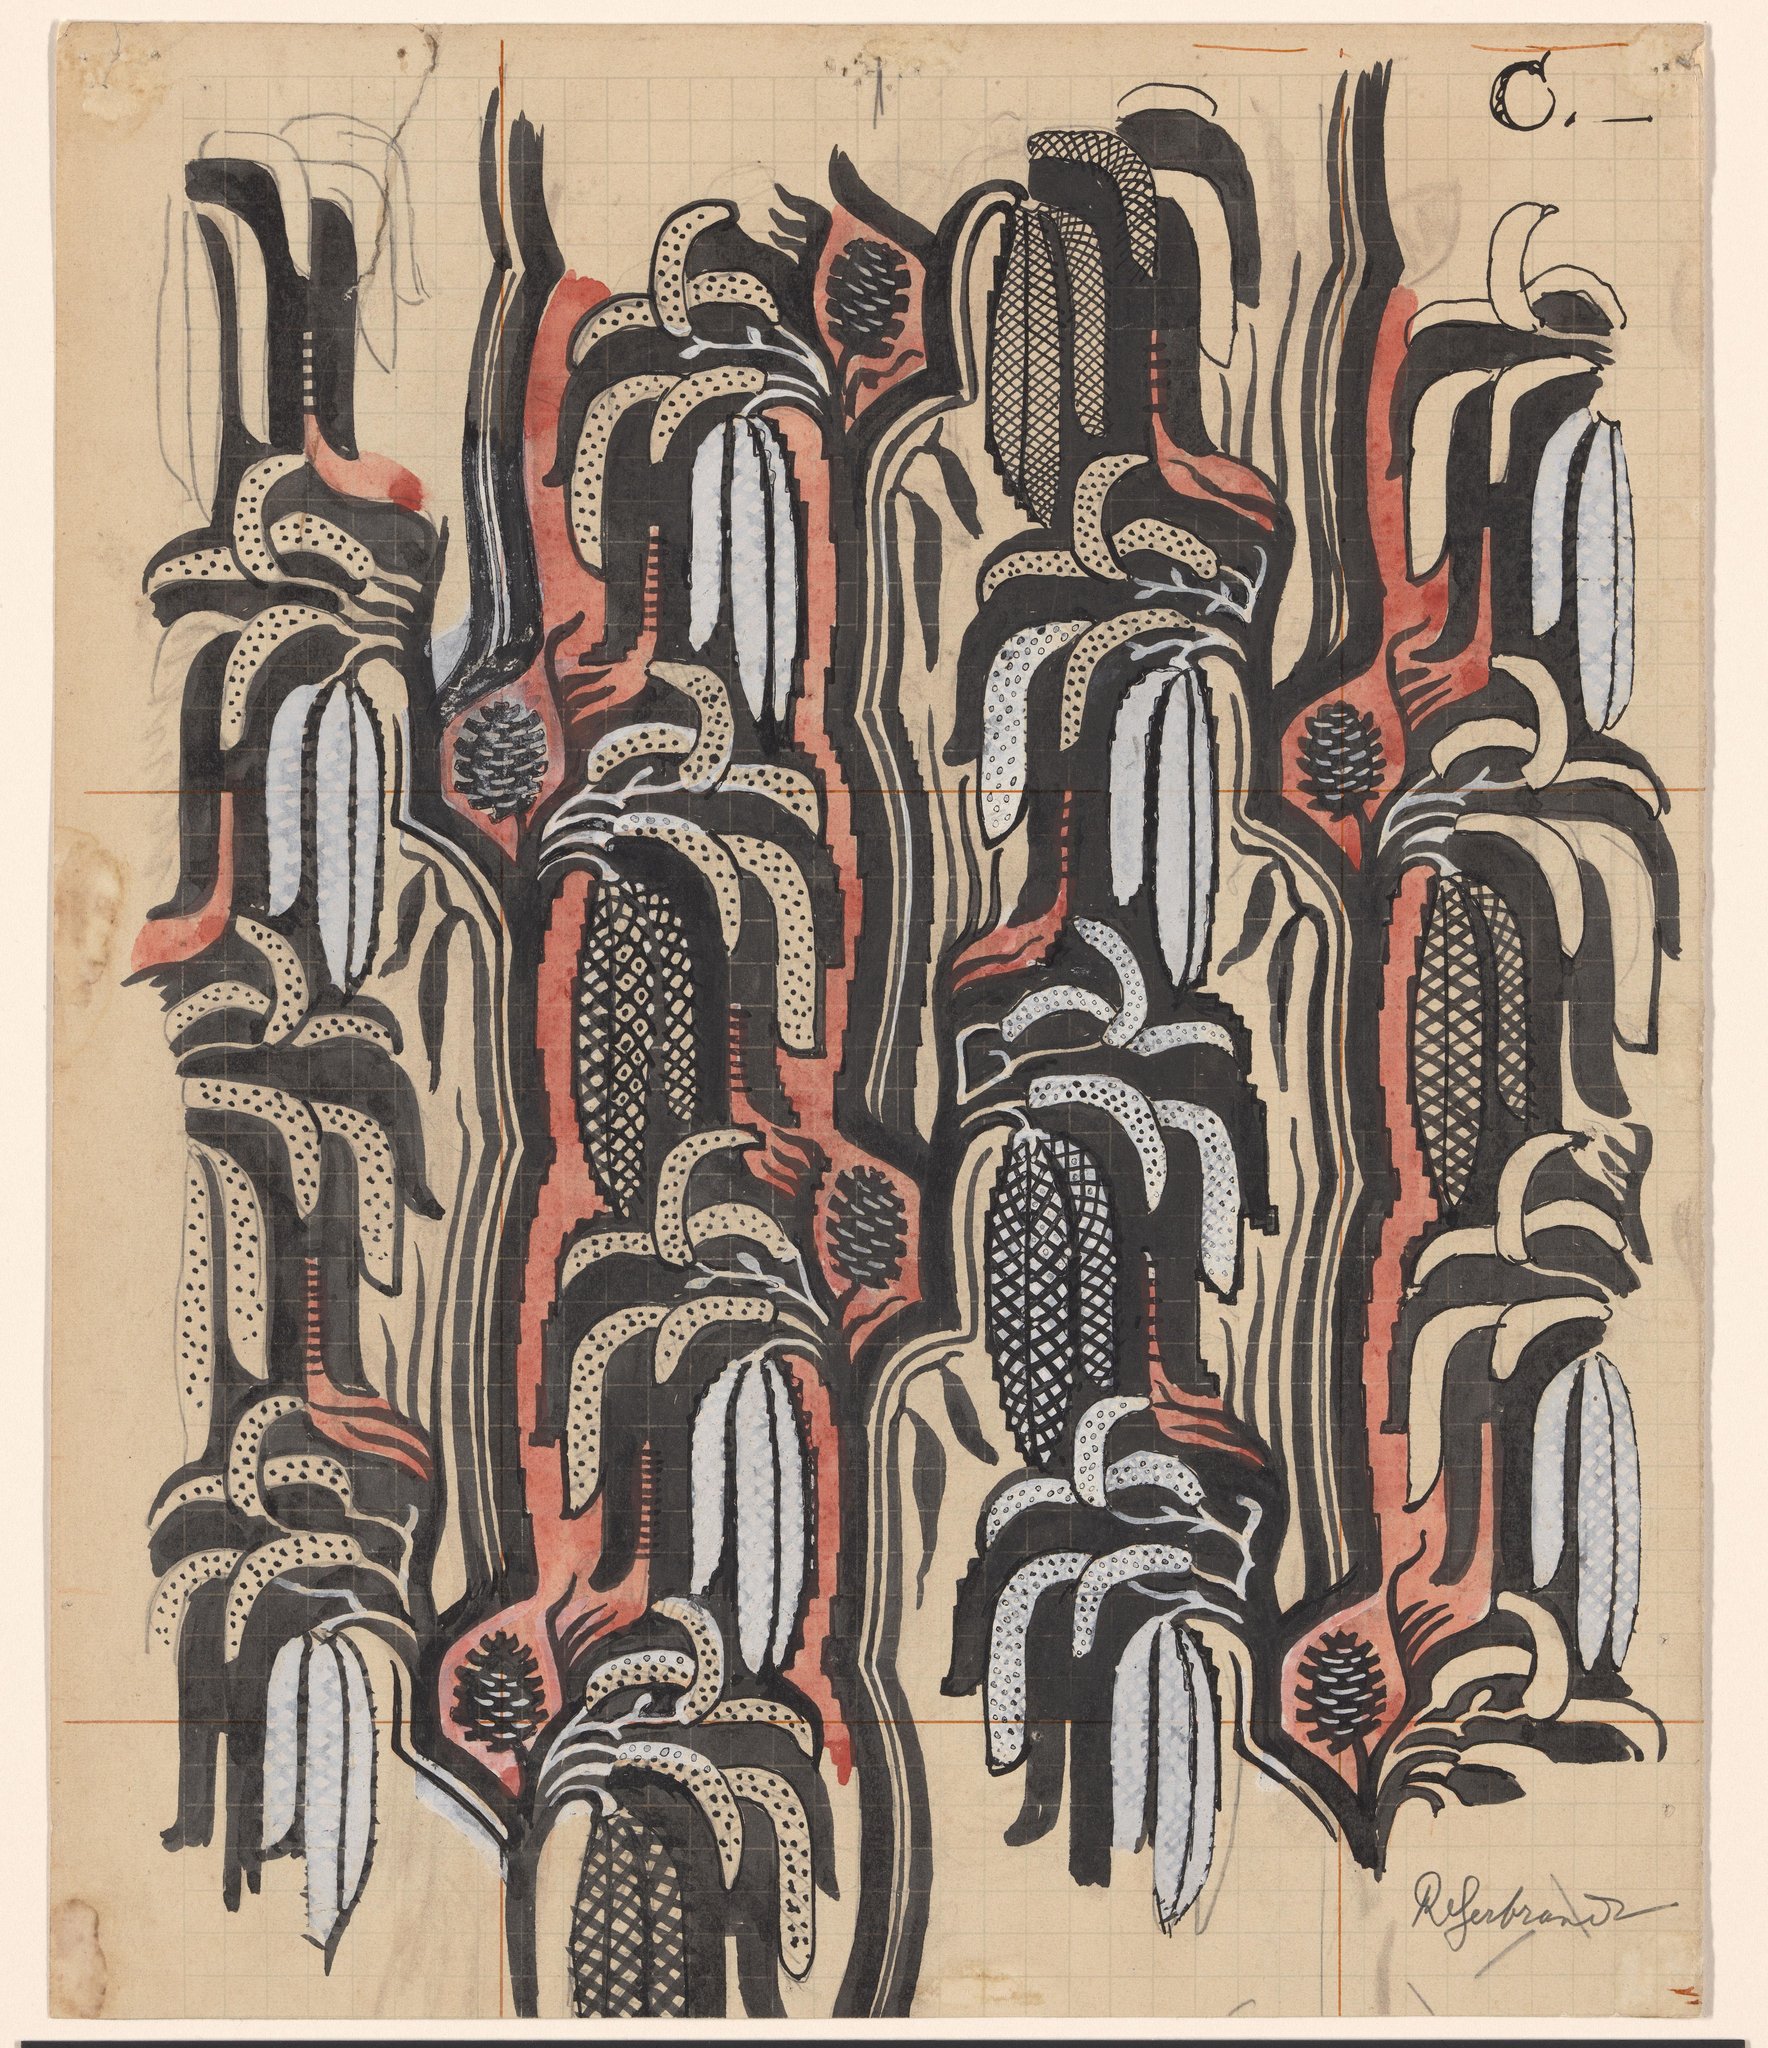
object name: design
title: Decorative Designs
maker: roelf gerbrands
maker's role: designer, draughtsman, print maker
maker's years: 1891-1954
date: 1921-1954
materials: ink, pencil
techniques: brush, pen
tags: seed: catkin, fruits: alder, ornament derived from plant forms - aa - stylized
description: Flowering alder catkins, iris, and animals constitute the point of departure for these decorative designs by Roelf Gerbrands. They probably date from the 1920s. He took into account the purpose of the patterns in the flat and colourful styling: they were intended for printed furnishing textiles and wallpaper. Gerbrands also produced designs for calendars, posters, as well as stained glass.